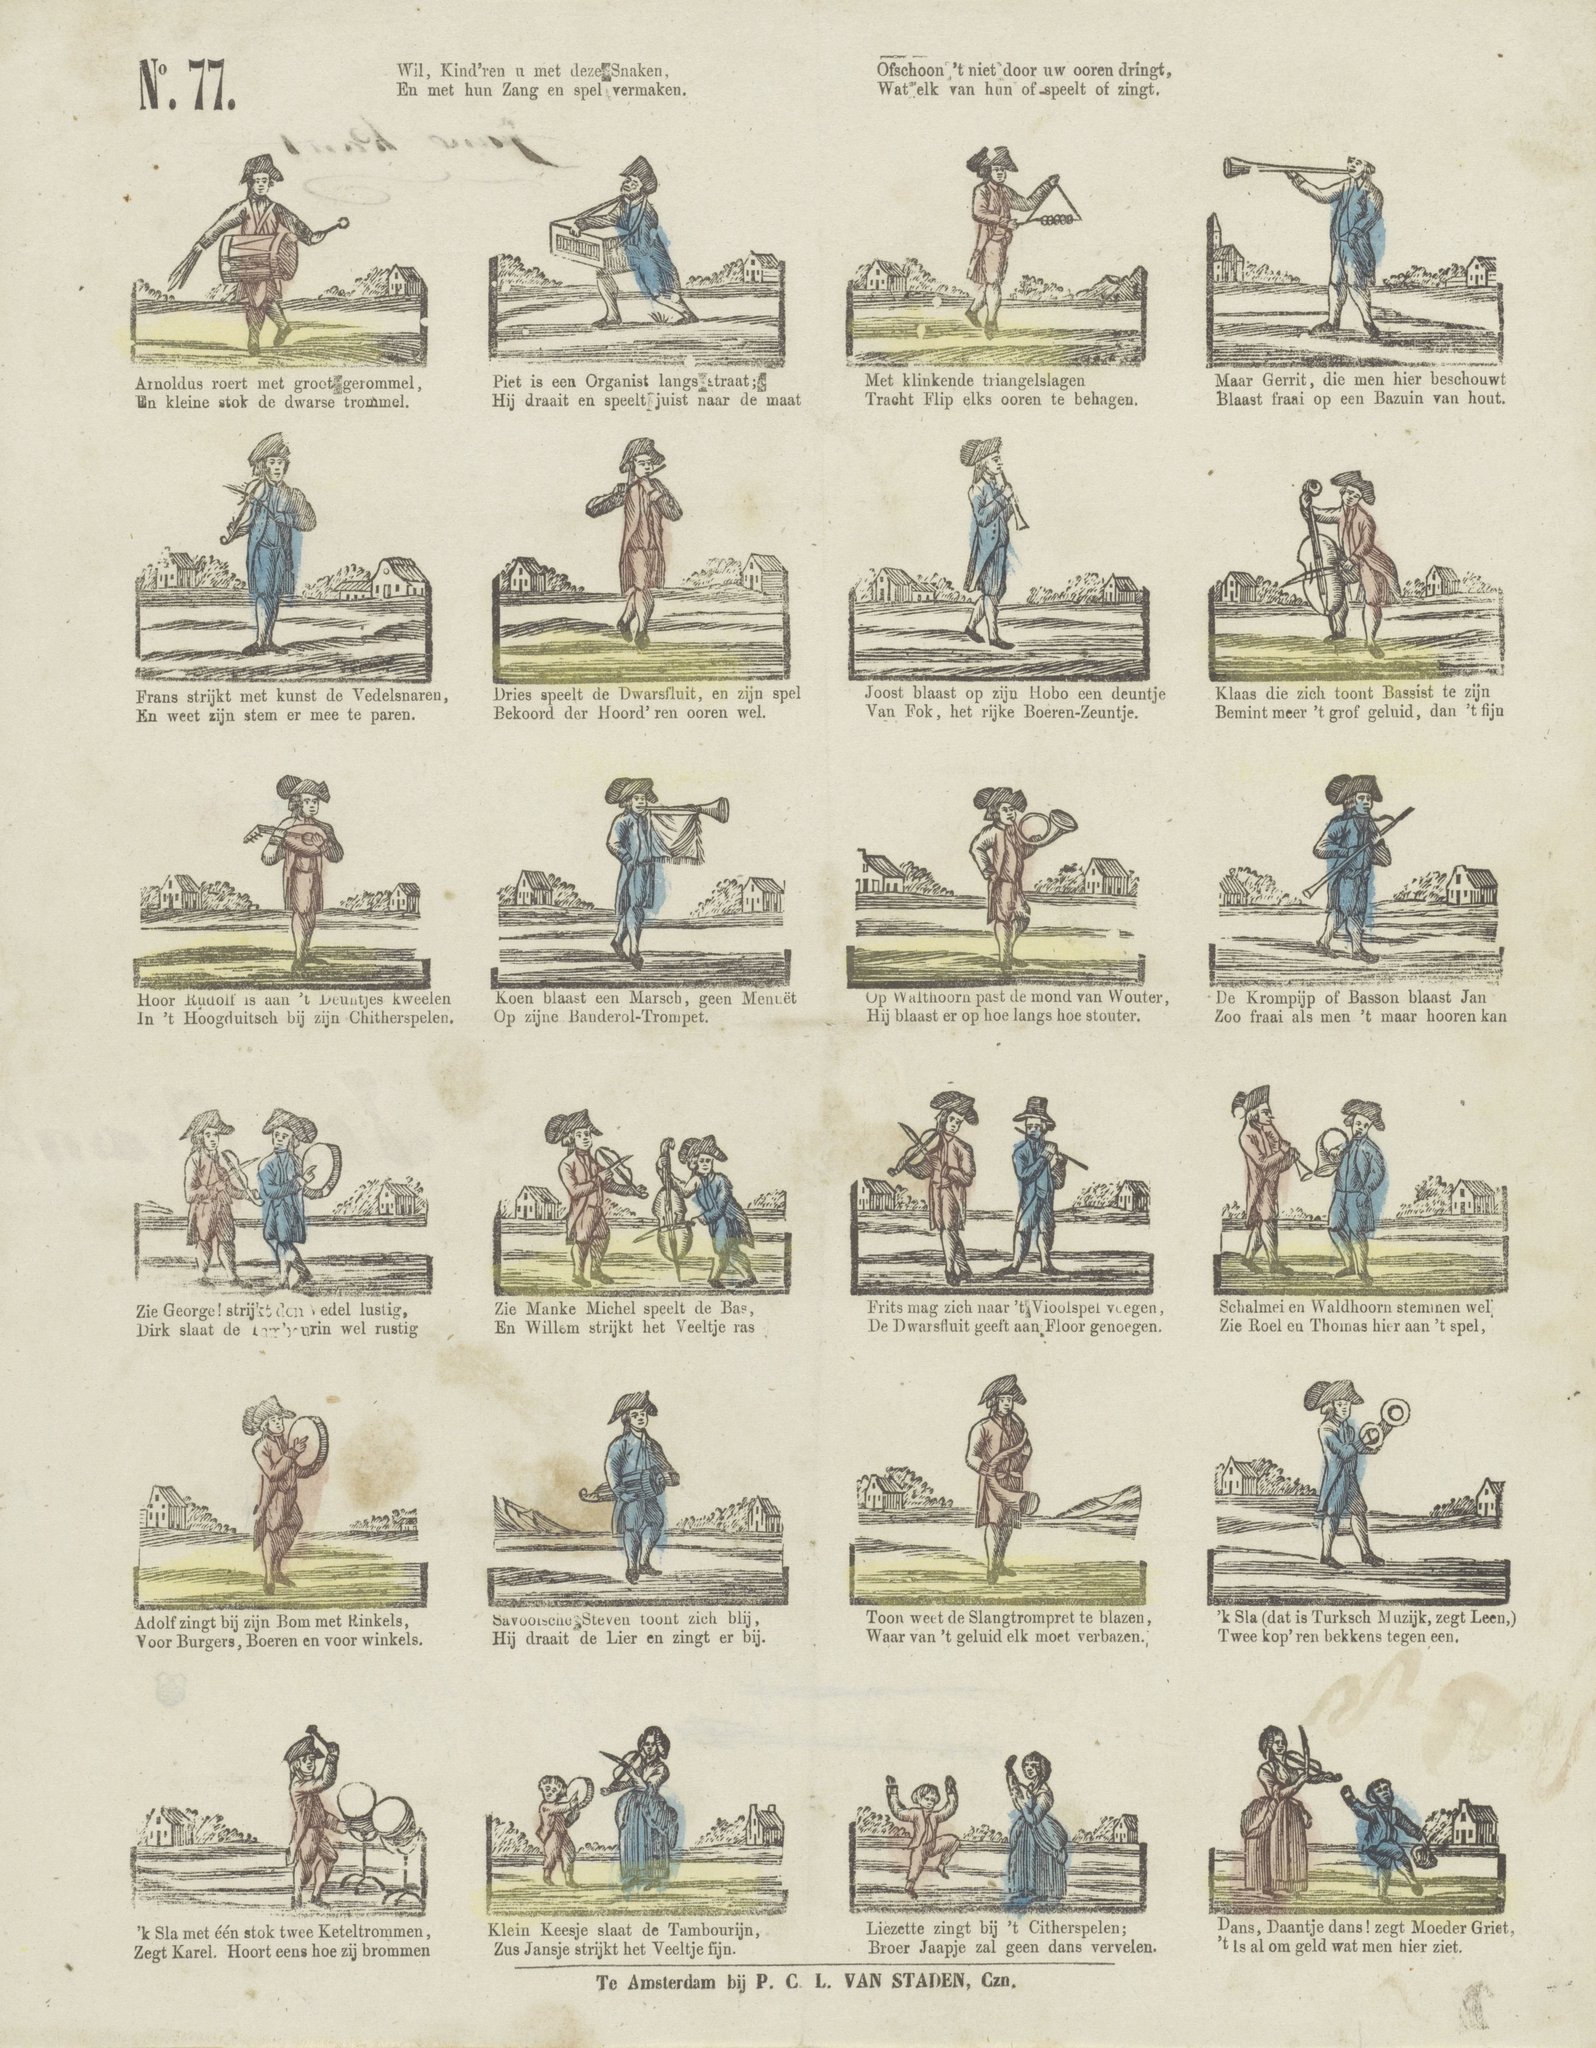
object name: print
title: Wil, kind'ren u met deze snaken, / En met hun zang en spel vermaken. / Ofschoon 't niet door uw ooren dringt, / Wat elk van hun of speelt of zingt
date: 1850-1870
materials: paper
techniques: colour, letterpress printing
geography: amsterdam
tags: musician at work, making music; musician with instrument, dancing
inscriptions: inscription: ‘Jan Kant’, inscription, collector's mark: Lugt 2760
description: Blad met 24 voorstellingen van muzikanten en dansers. Onder elke voorstelling een tweeregelig vers. Genummerd linksboven: No. 77.